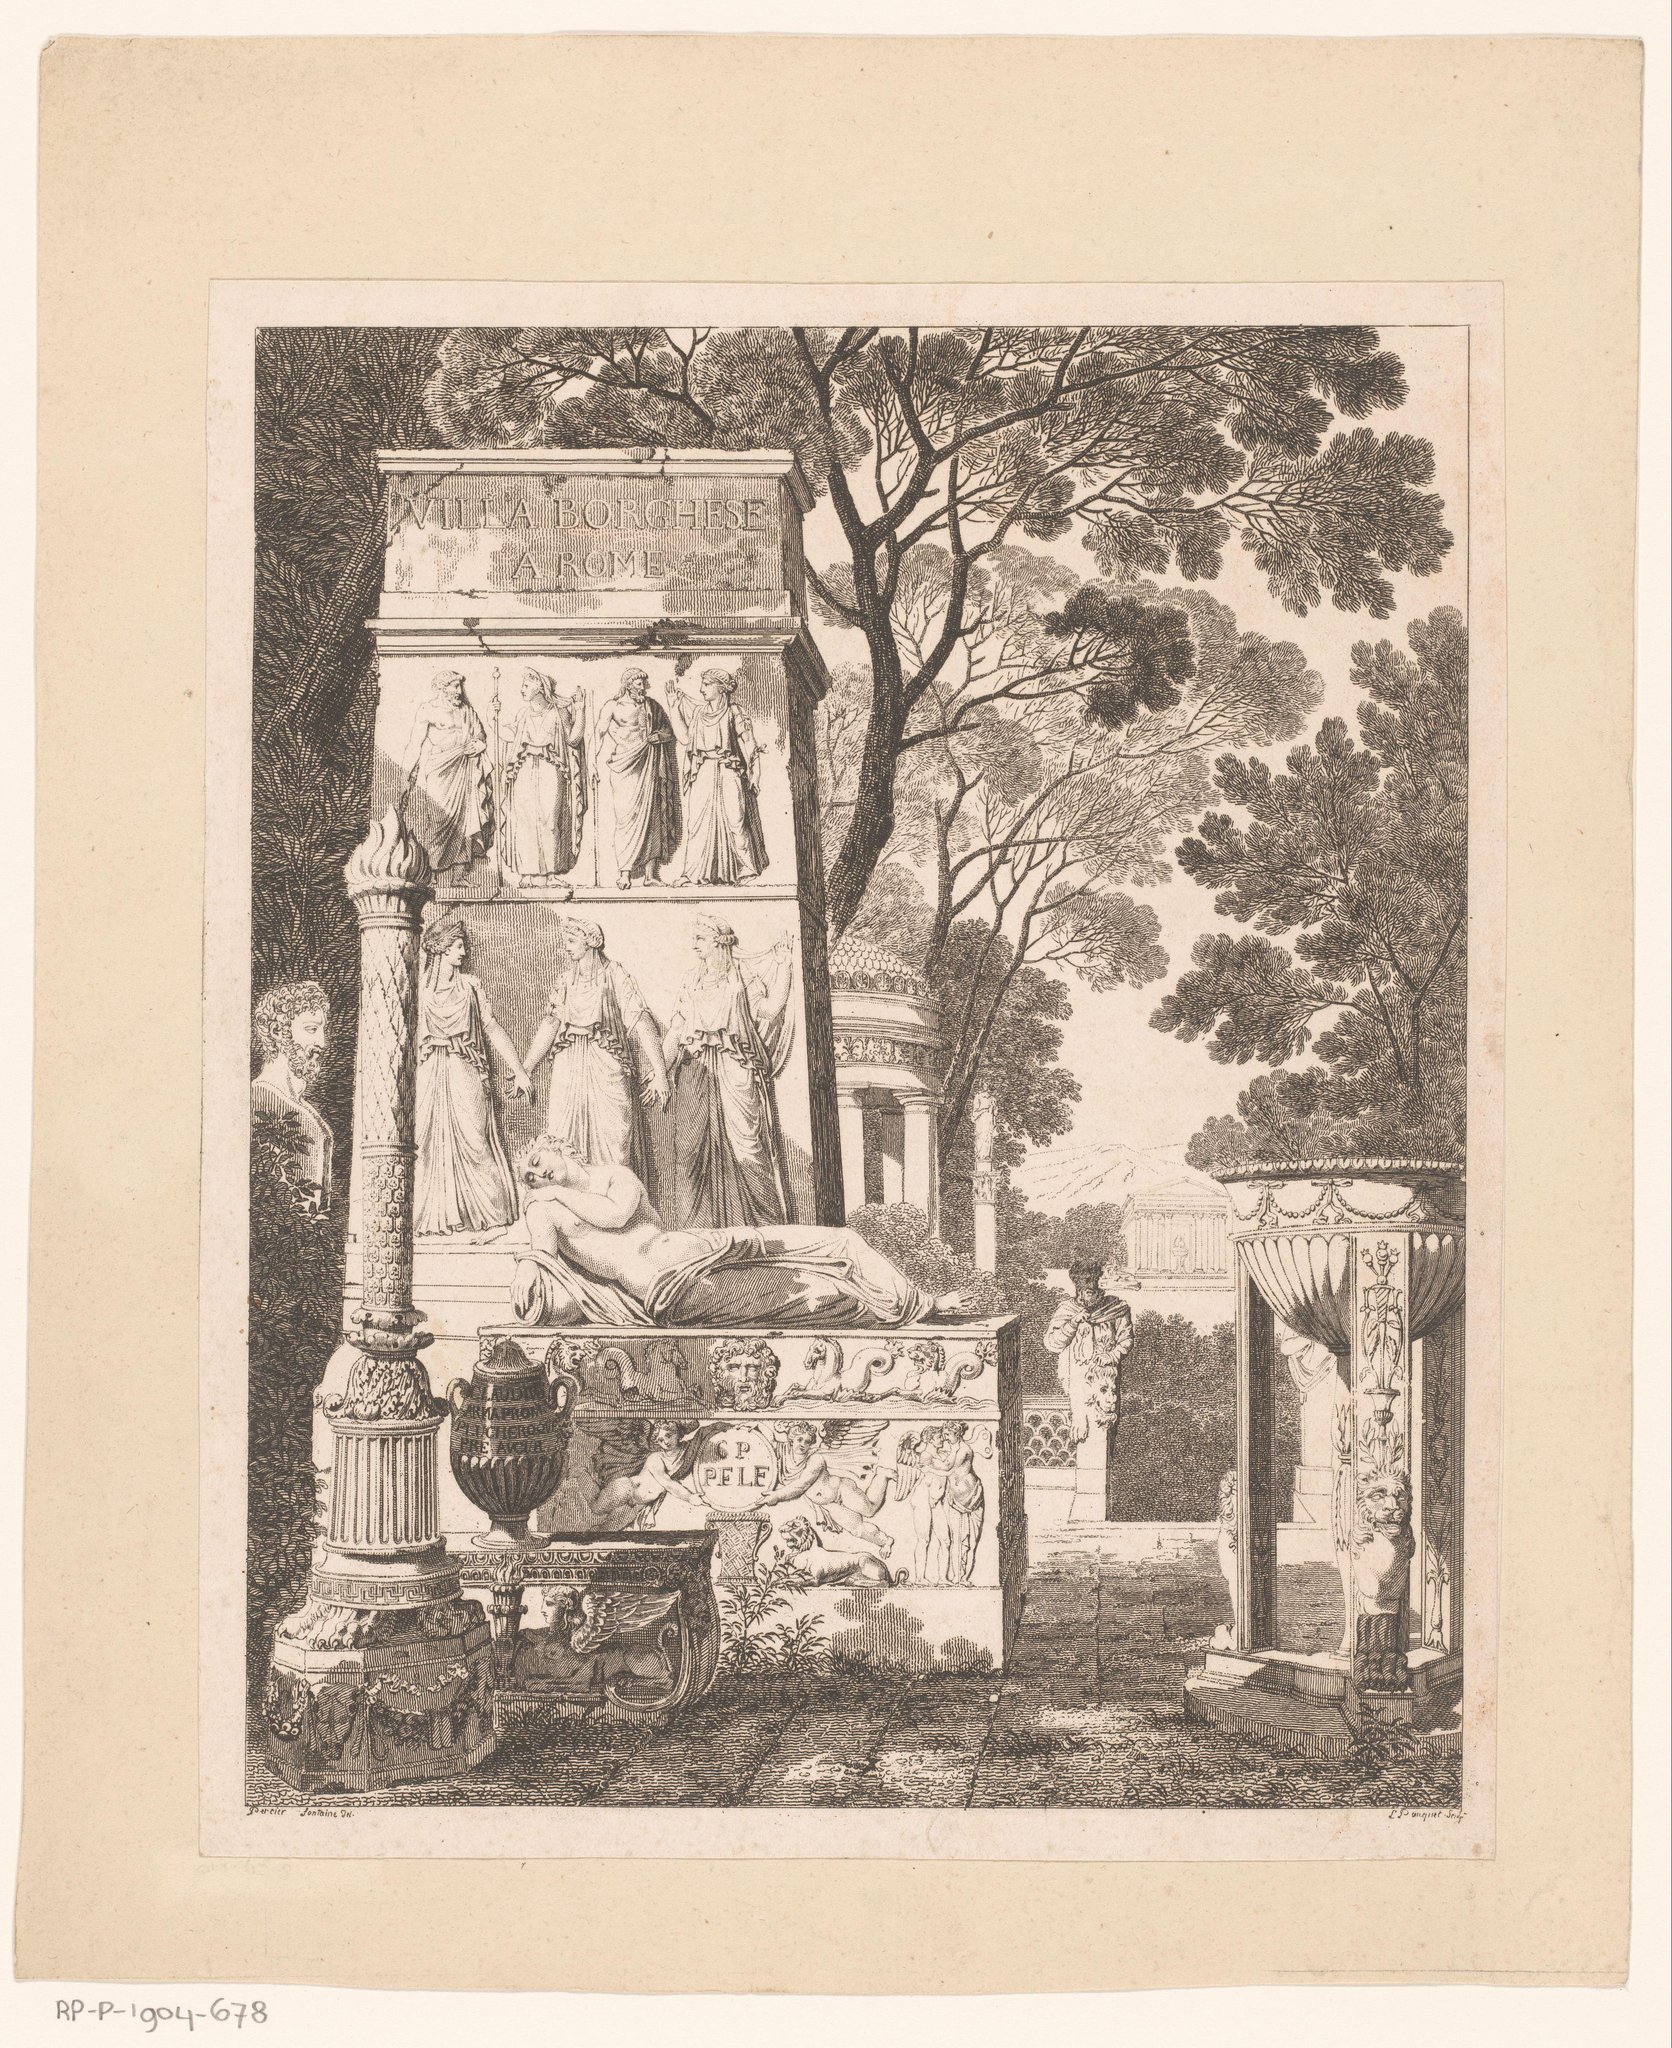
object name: print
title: Gezicht op ruïnes bij Villa Borghese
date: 1774-1838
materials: paper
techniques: etching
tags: landscape with ruins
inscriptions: collector's mark: Lugt 2228